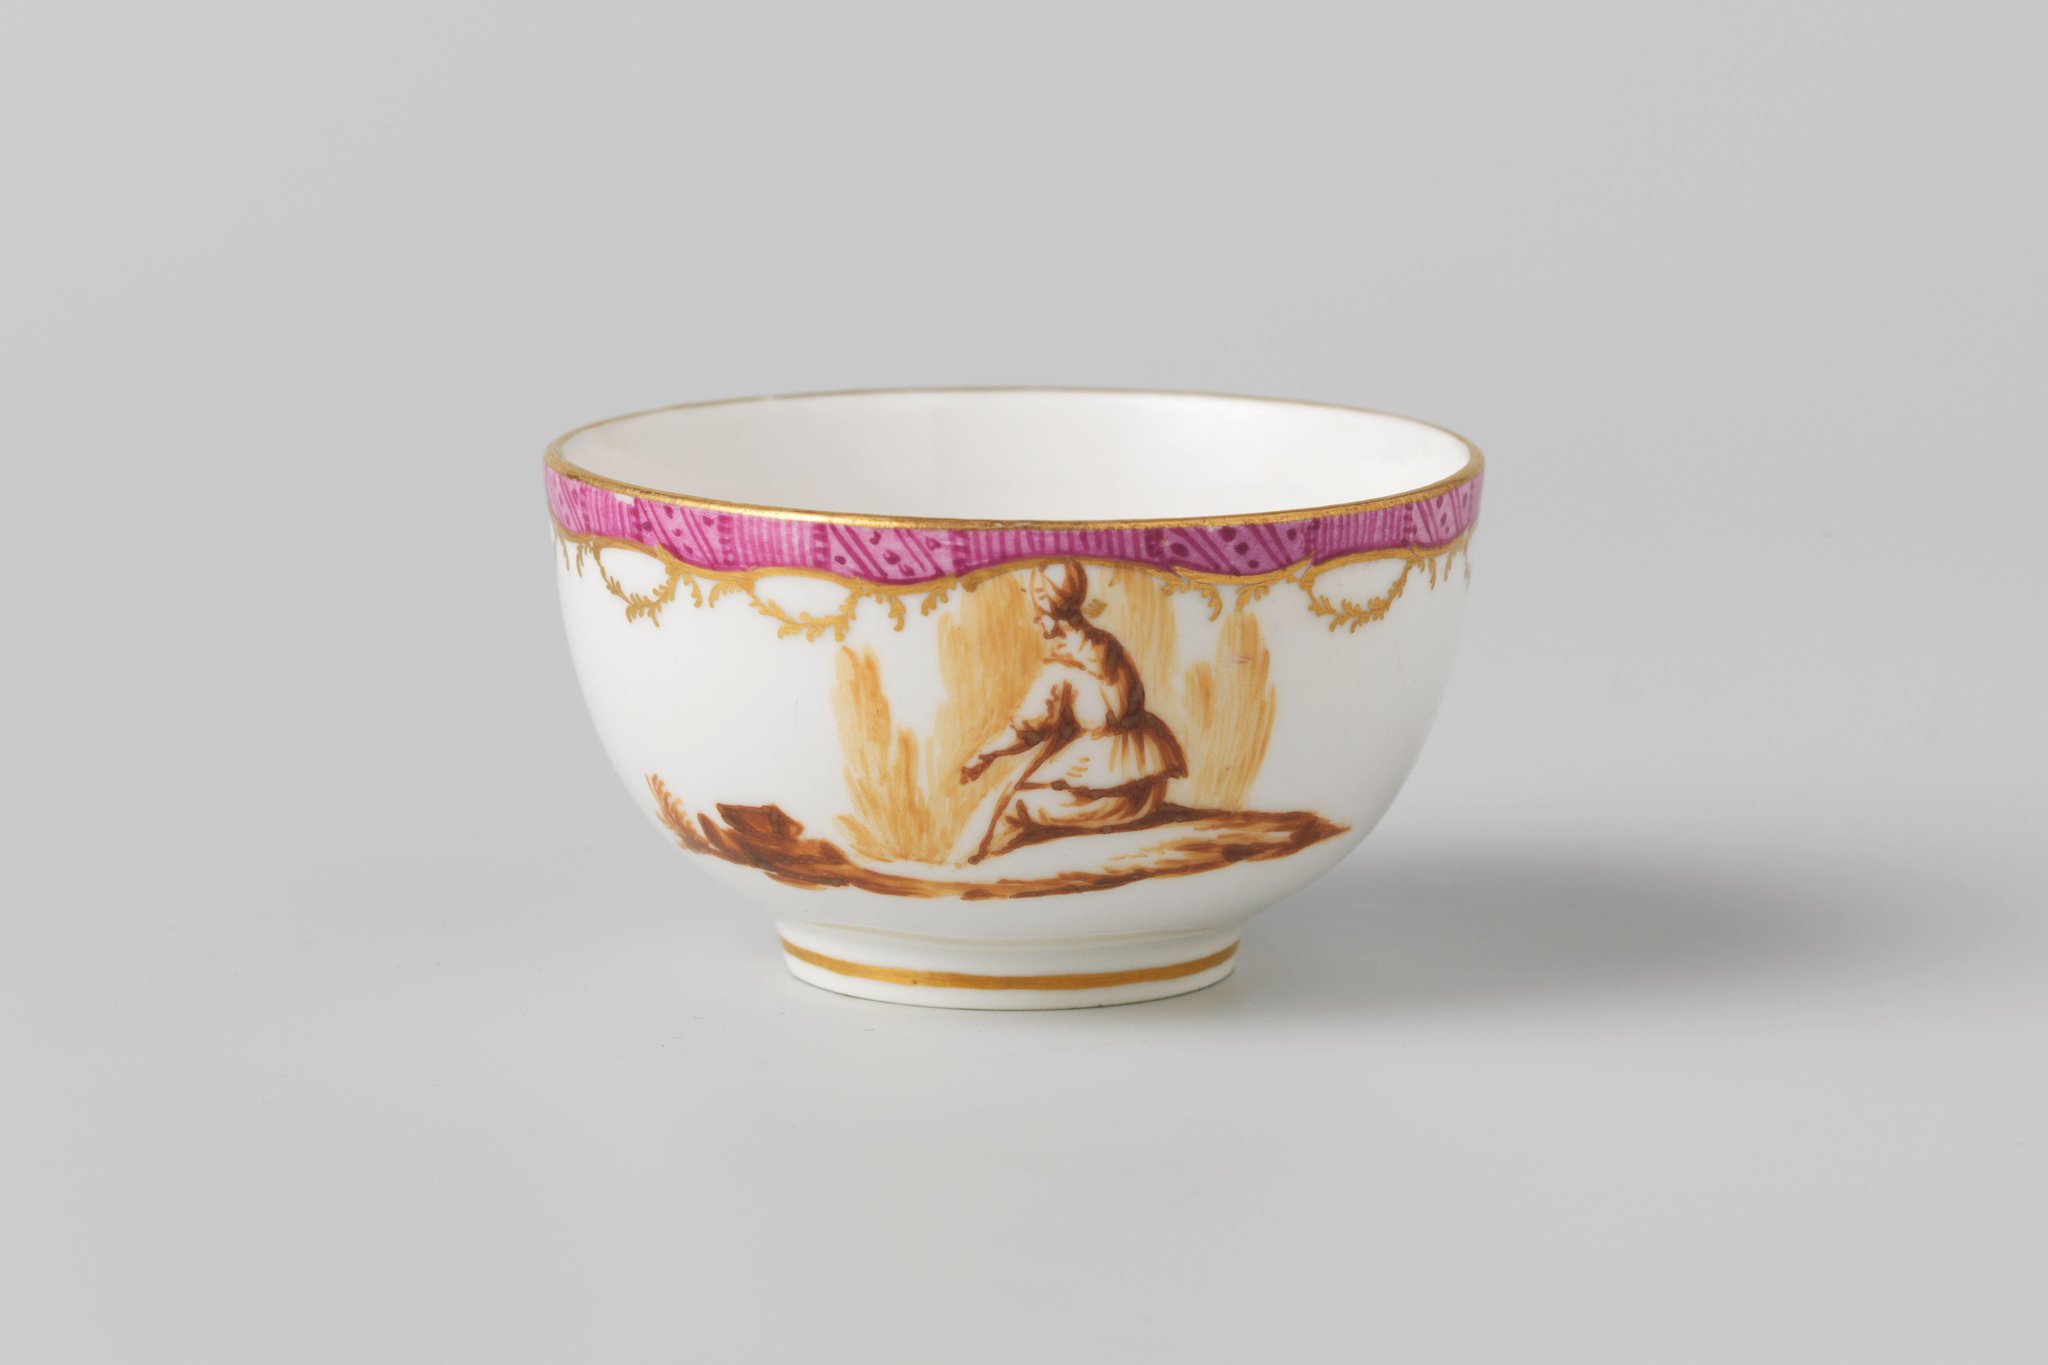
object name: tea cup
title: Theekop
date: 1774-1778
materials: porcelain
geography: loosdrecht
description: Theekop zonder oor van porselein. Beschilderd in sepia met figuren in een landschap. Langs de randen een lila fries tussen gouden biezen.